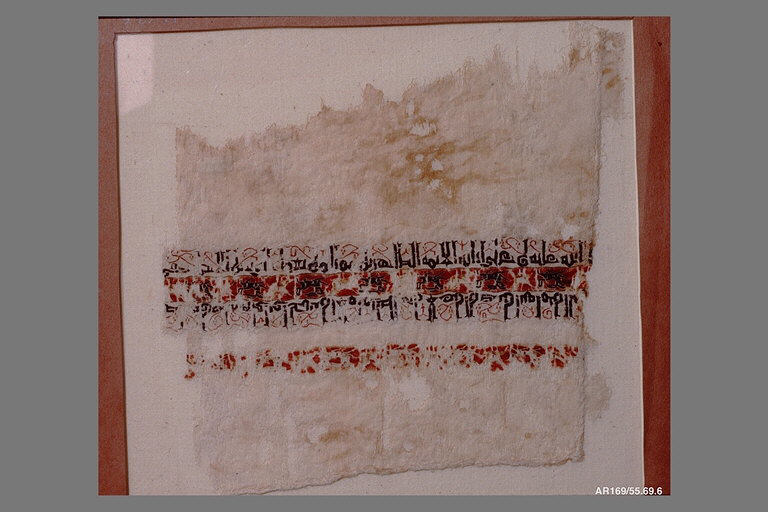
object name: textile fragment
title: Tiraz Fragment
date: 1020-1035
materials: linen, silk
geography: egypt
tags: arabic